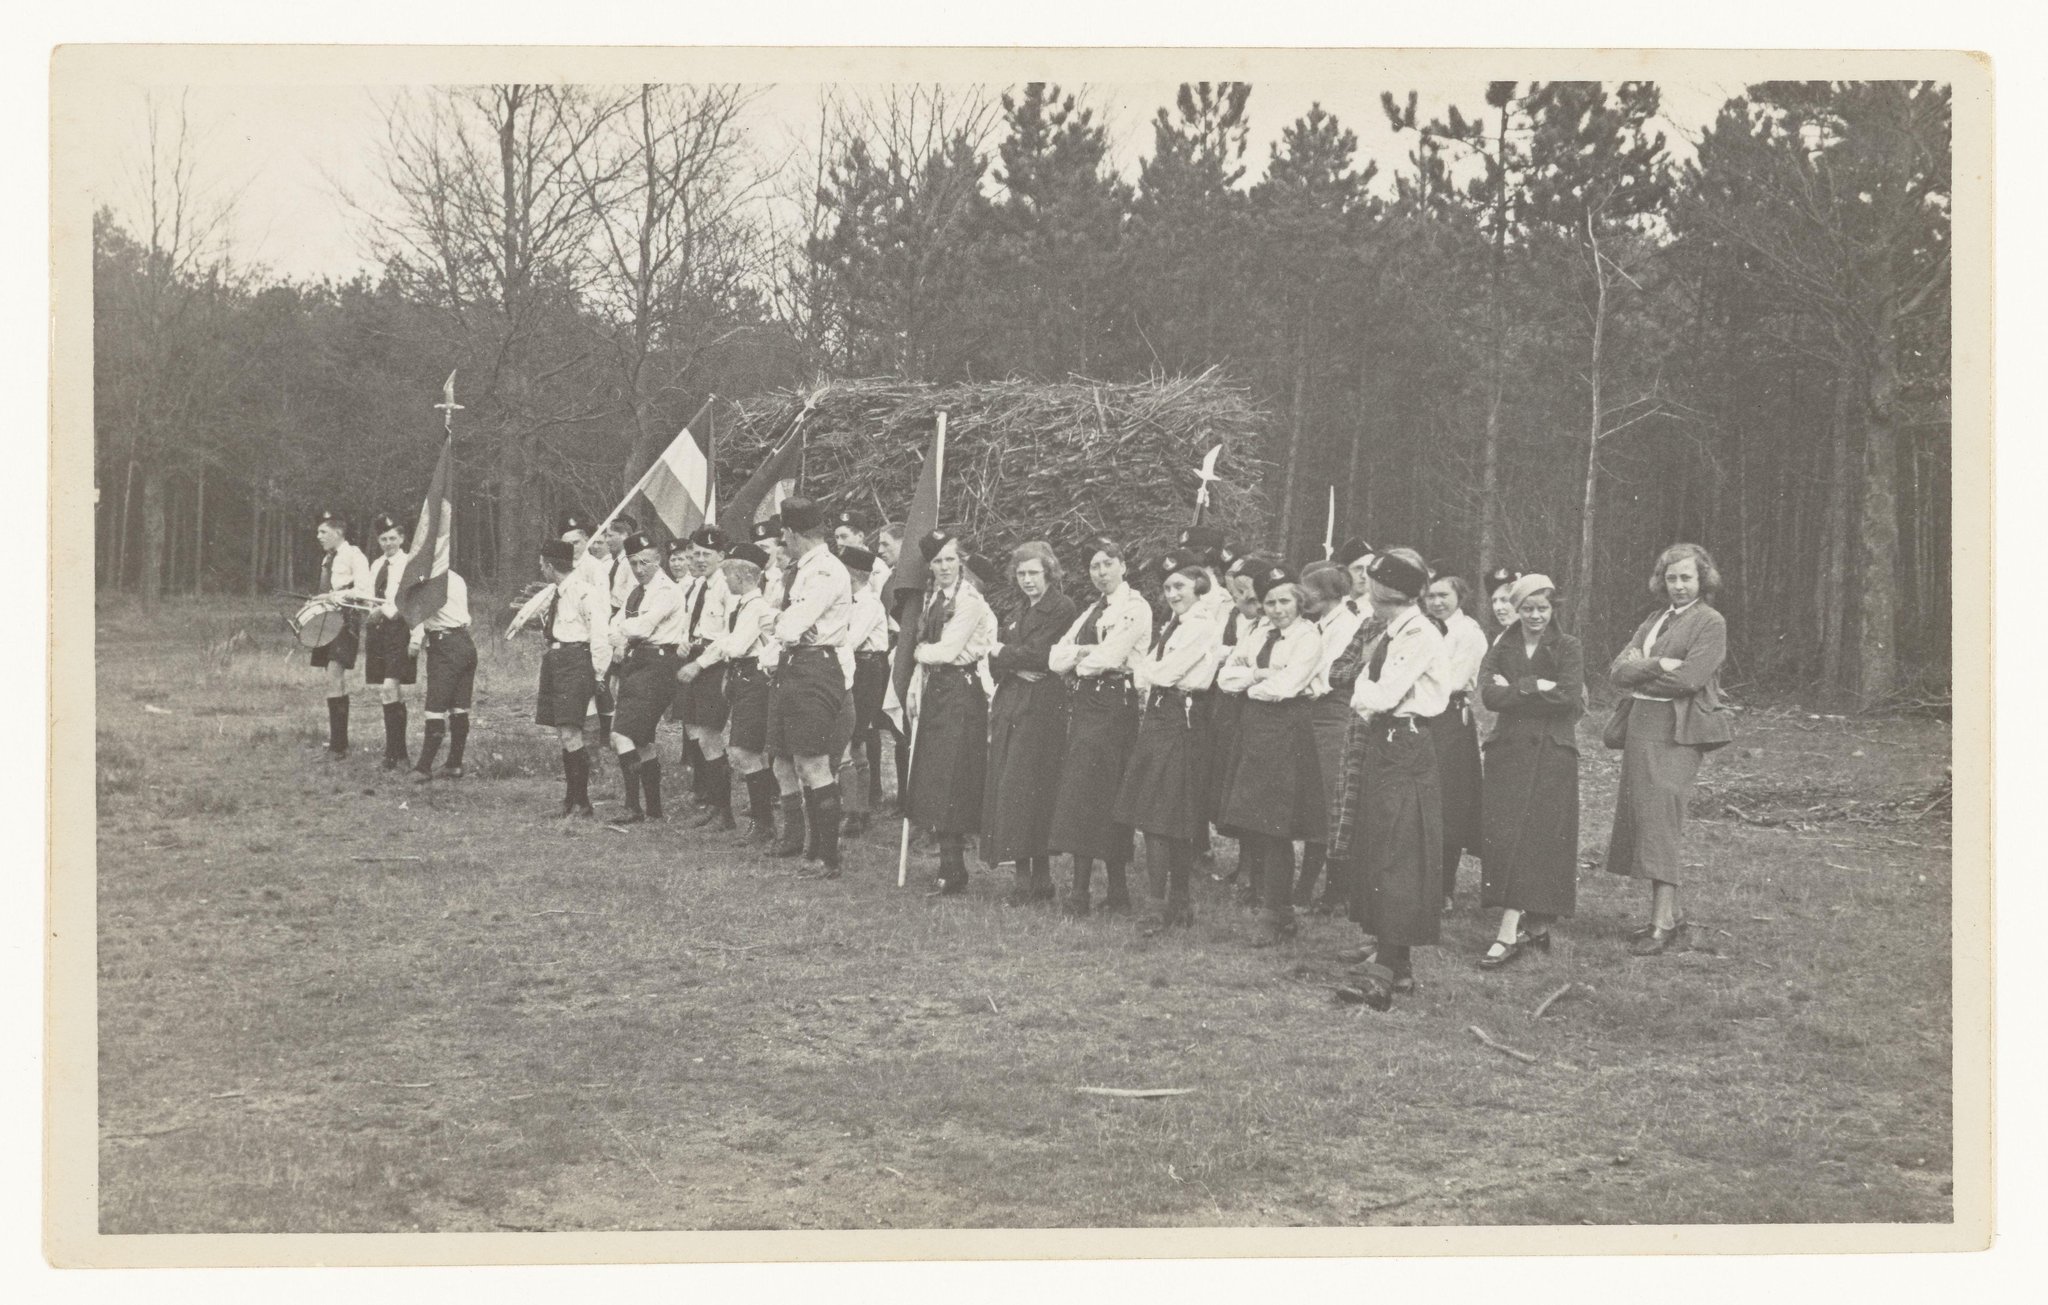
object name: photograph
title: Na afloop van de optocht Jeugdstorm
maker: j. otto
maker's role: fotograaf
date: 1935-1937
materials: photographic support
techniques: photography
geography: zeist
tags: military parade, pageant, zeist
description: In een bosachtige omgeving staan jongens en meisjes van de Jeugdstorm en hun aanvoerders in uniform in informele houding, vermoedelijk na afloop van de optocht. Links jongens met trompetten en een trommel. In het midden zijn nog drie vlaggen te zien. Tussen de leden staan drie vrouwen in gewone kleding. Op de achtergrond een hoge houtstapel.